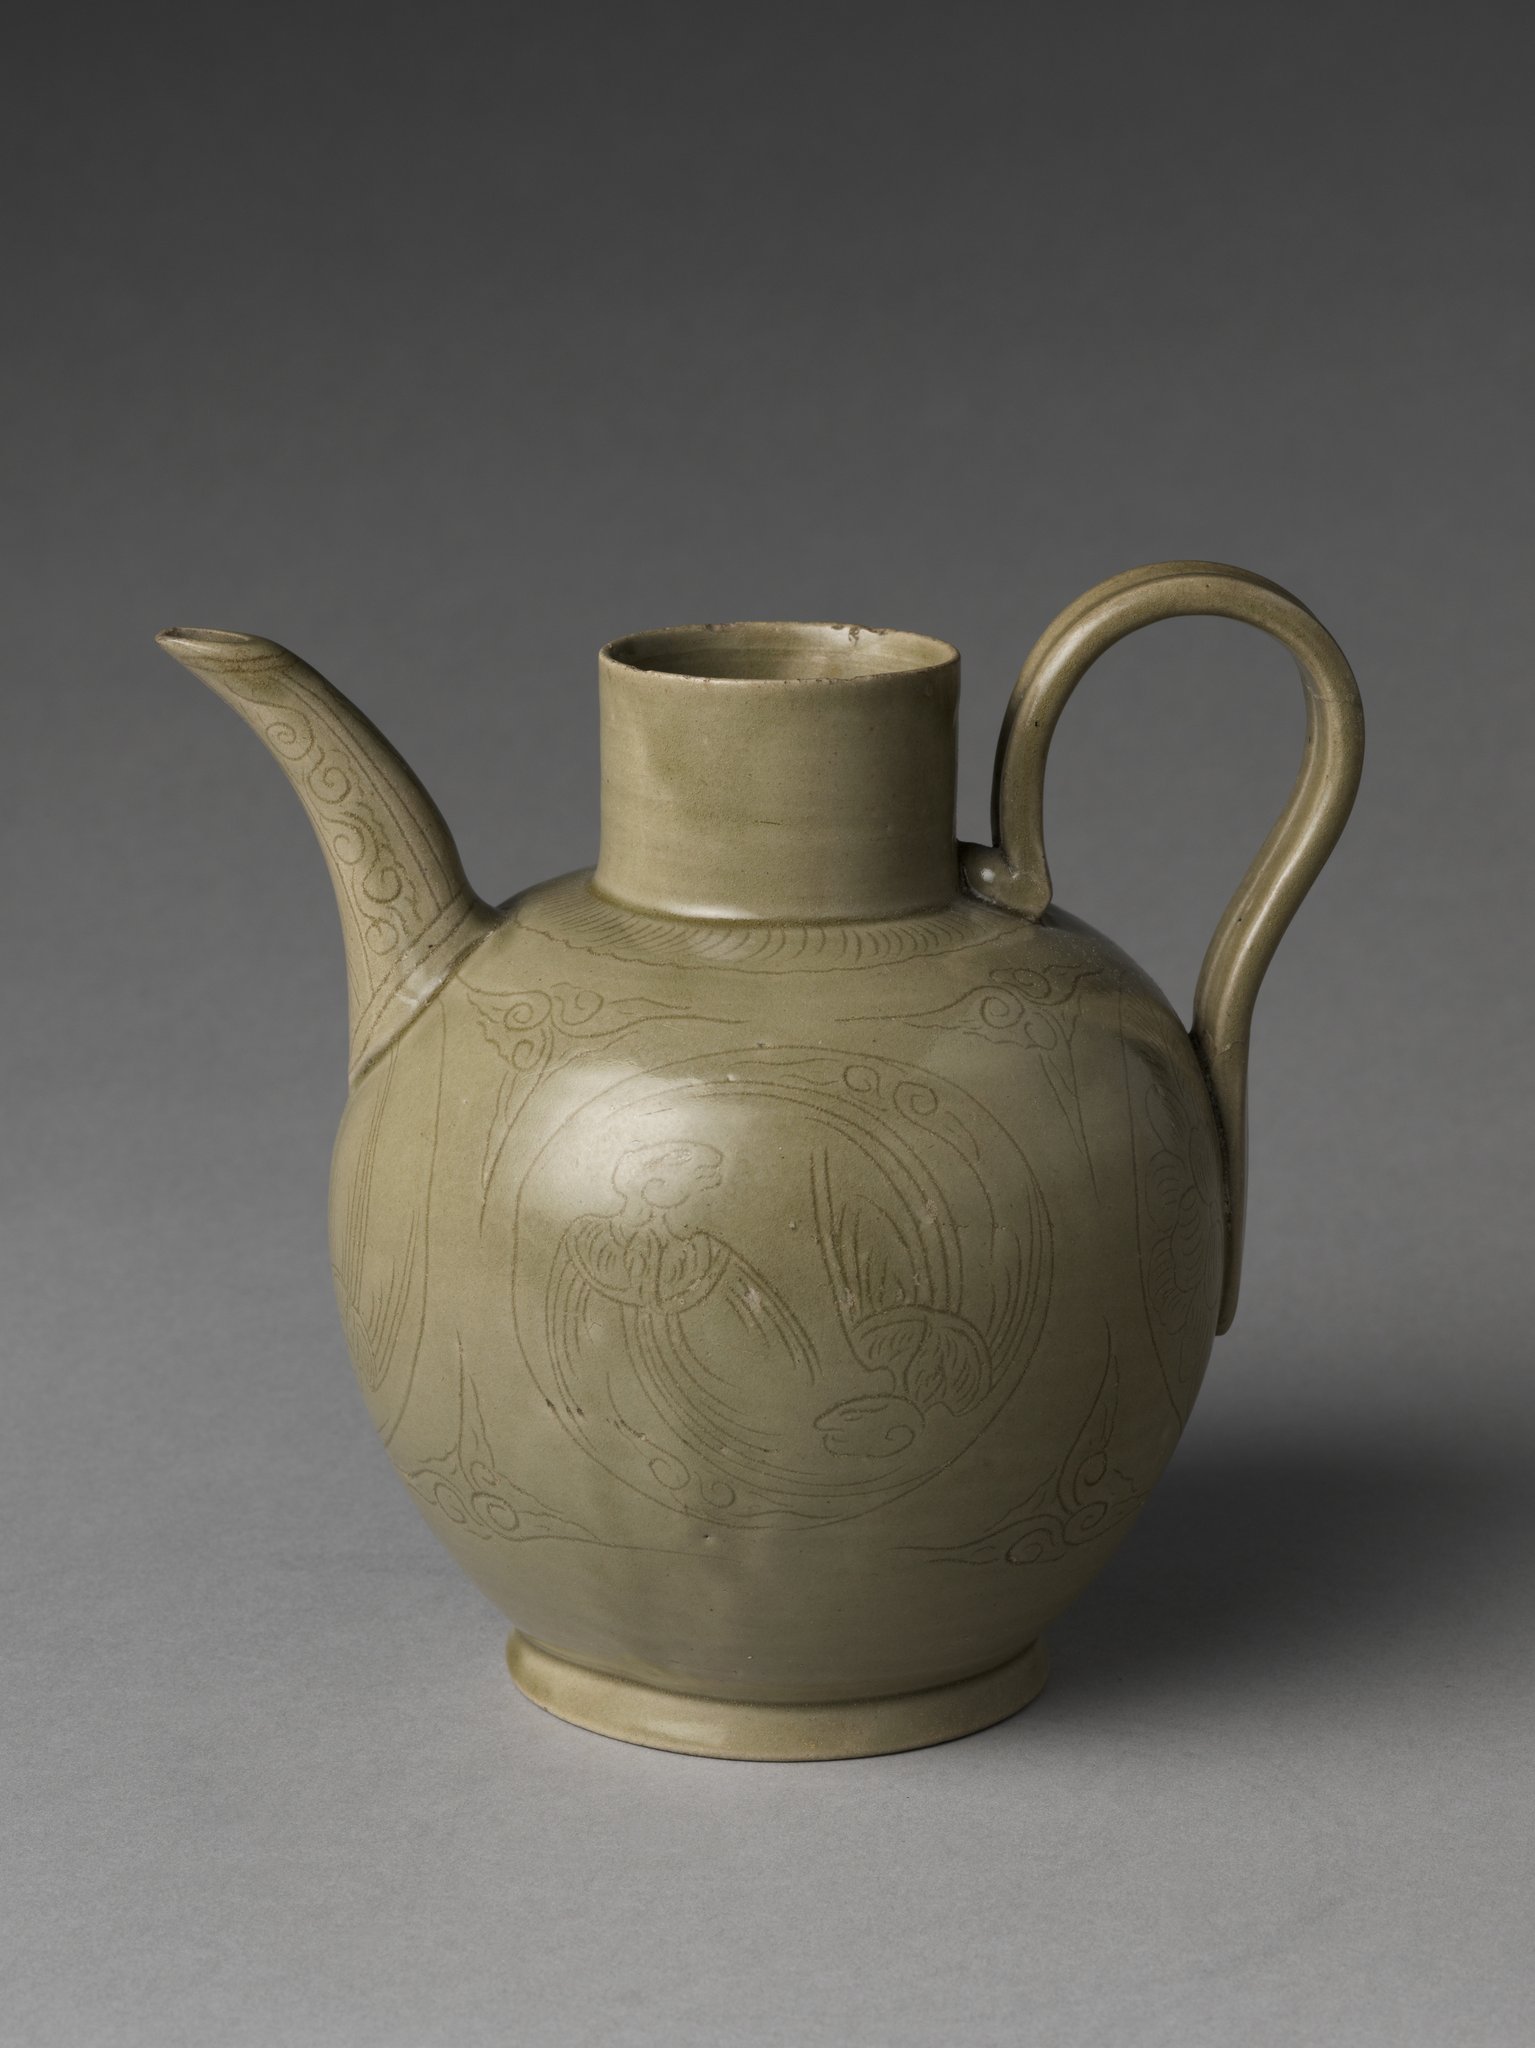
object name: ewer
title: Ewer with Parrots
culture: chinese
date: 901-1000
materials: ceramic glaze, glaze, stoneware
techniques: incising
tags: parrots